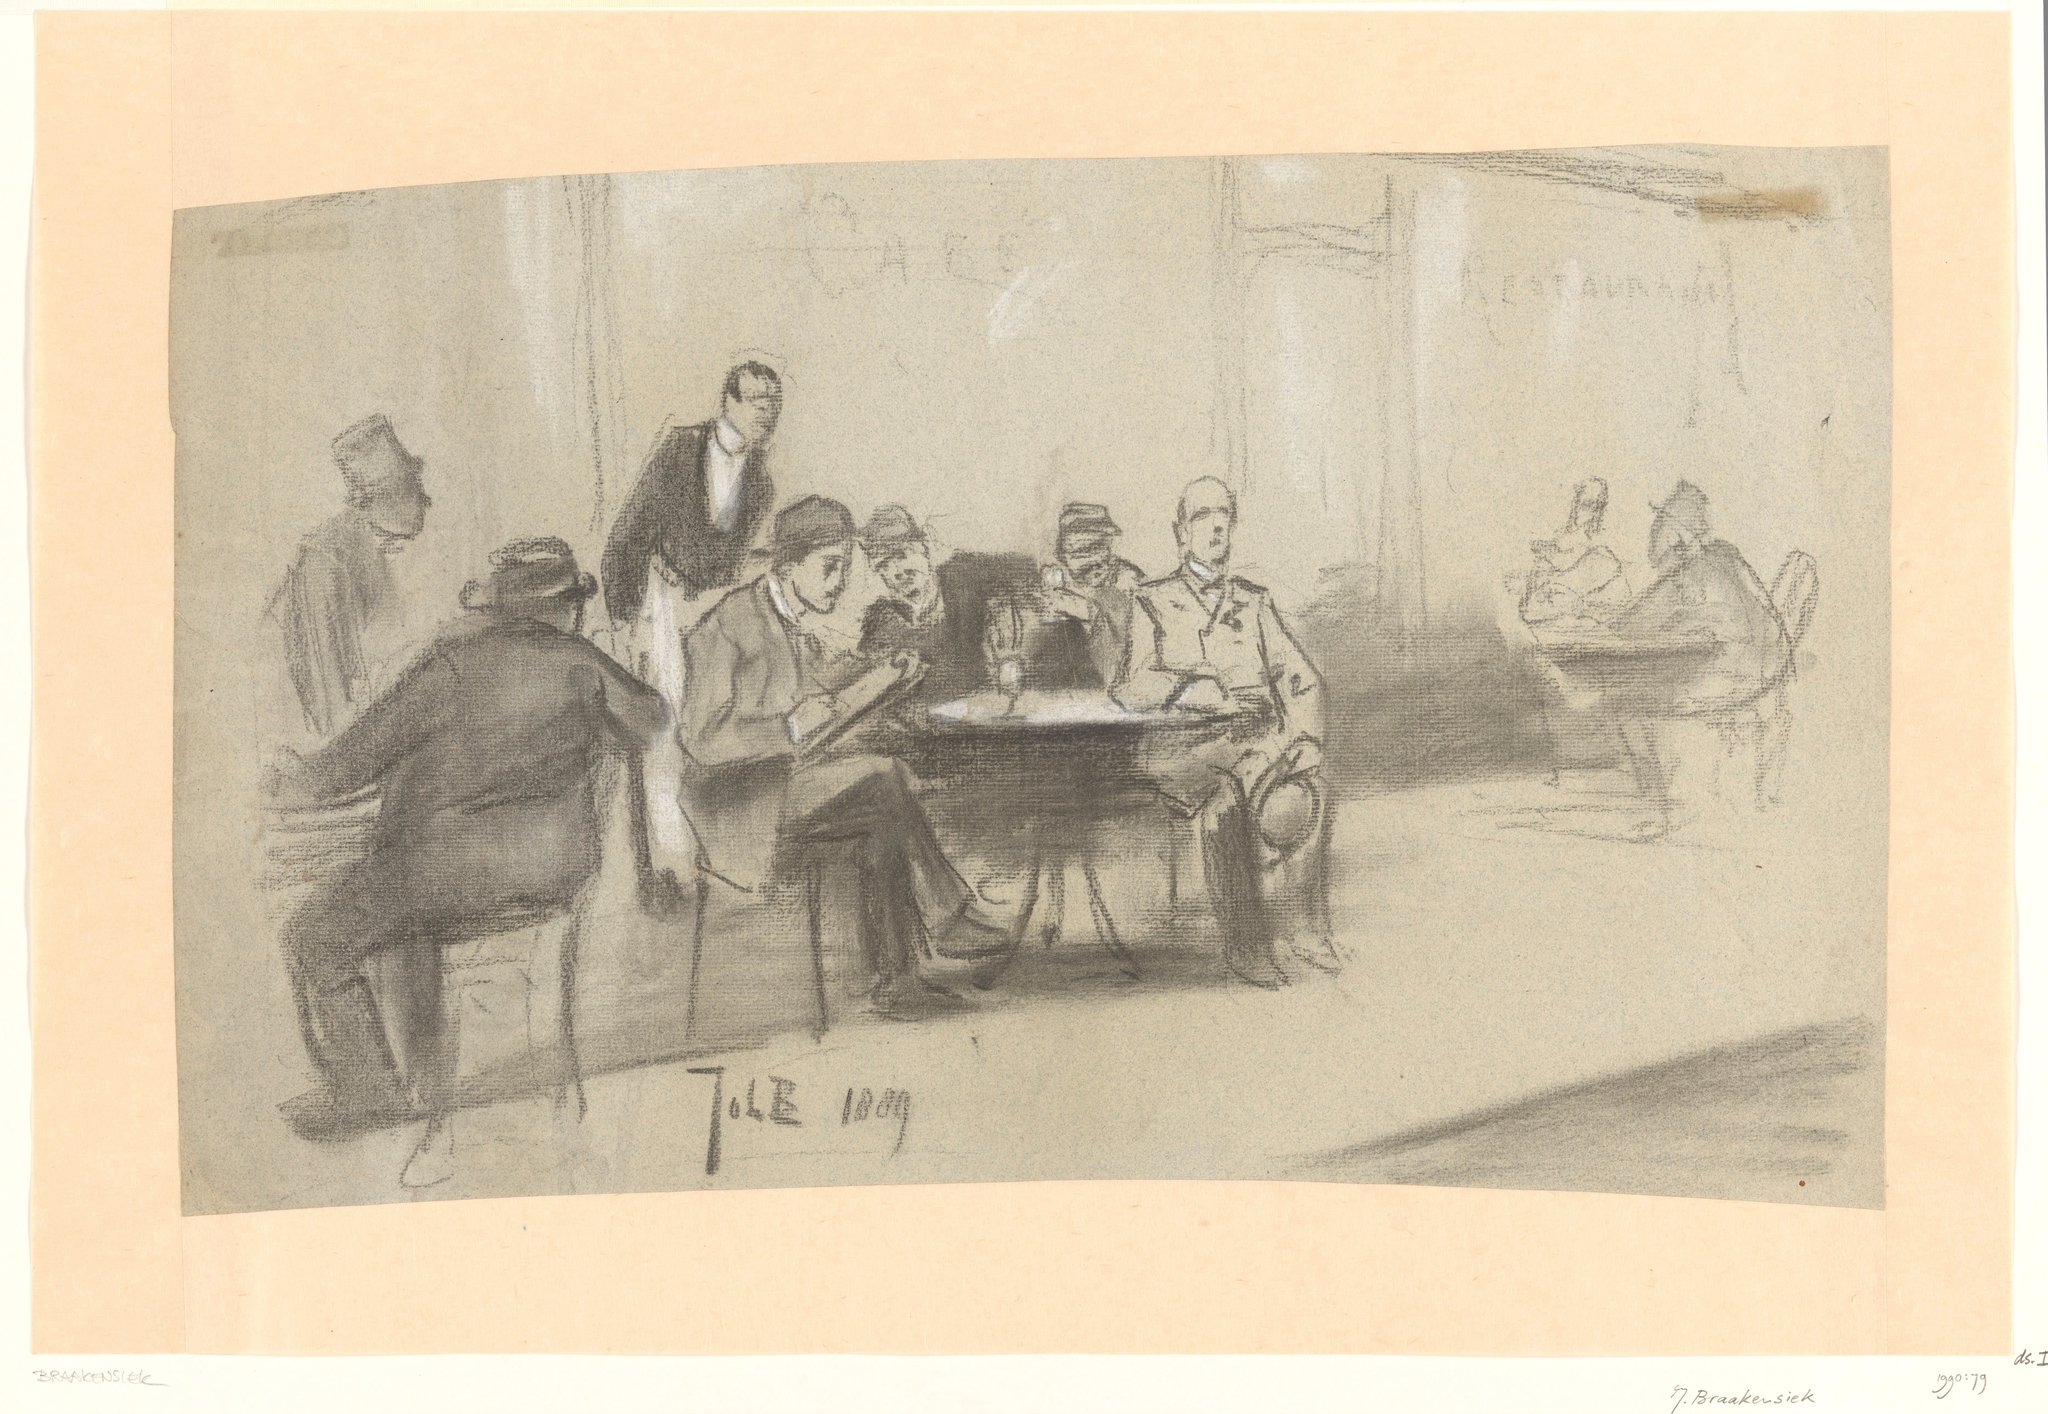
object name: drawing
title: Terras van een café-restaurant, met tekenende kunstenaar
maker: johan braakensiek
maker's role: draughtsman, print maker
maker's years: 1858-1940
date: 1889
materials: chalk, paper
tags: inn, coffee-house, public house, etc., draughtsman at work